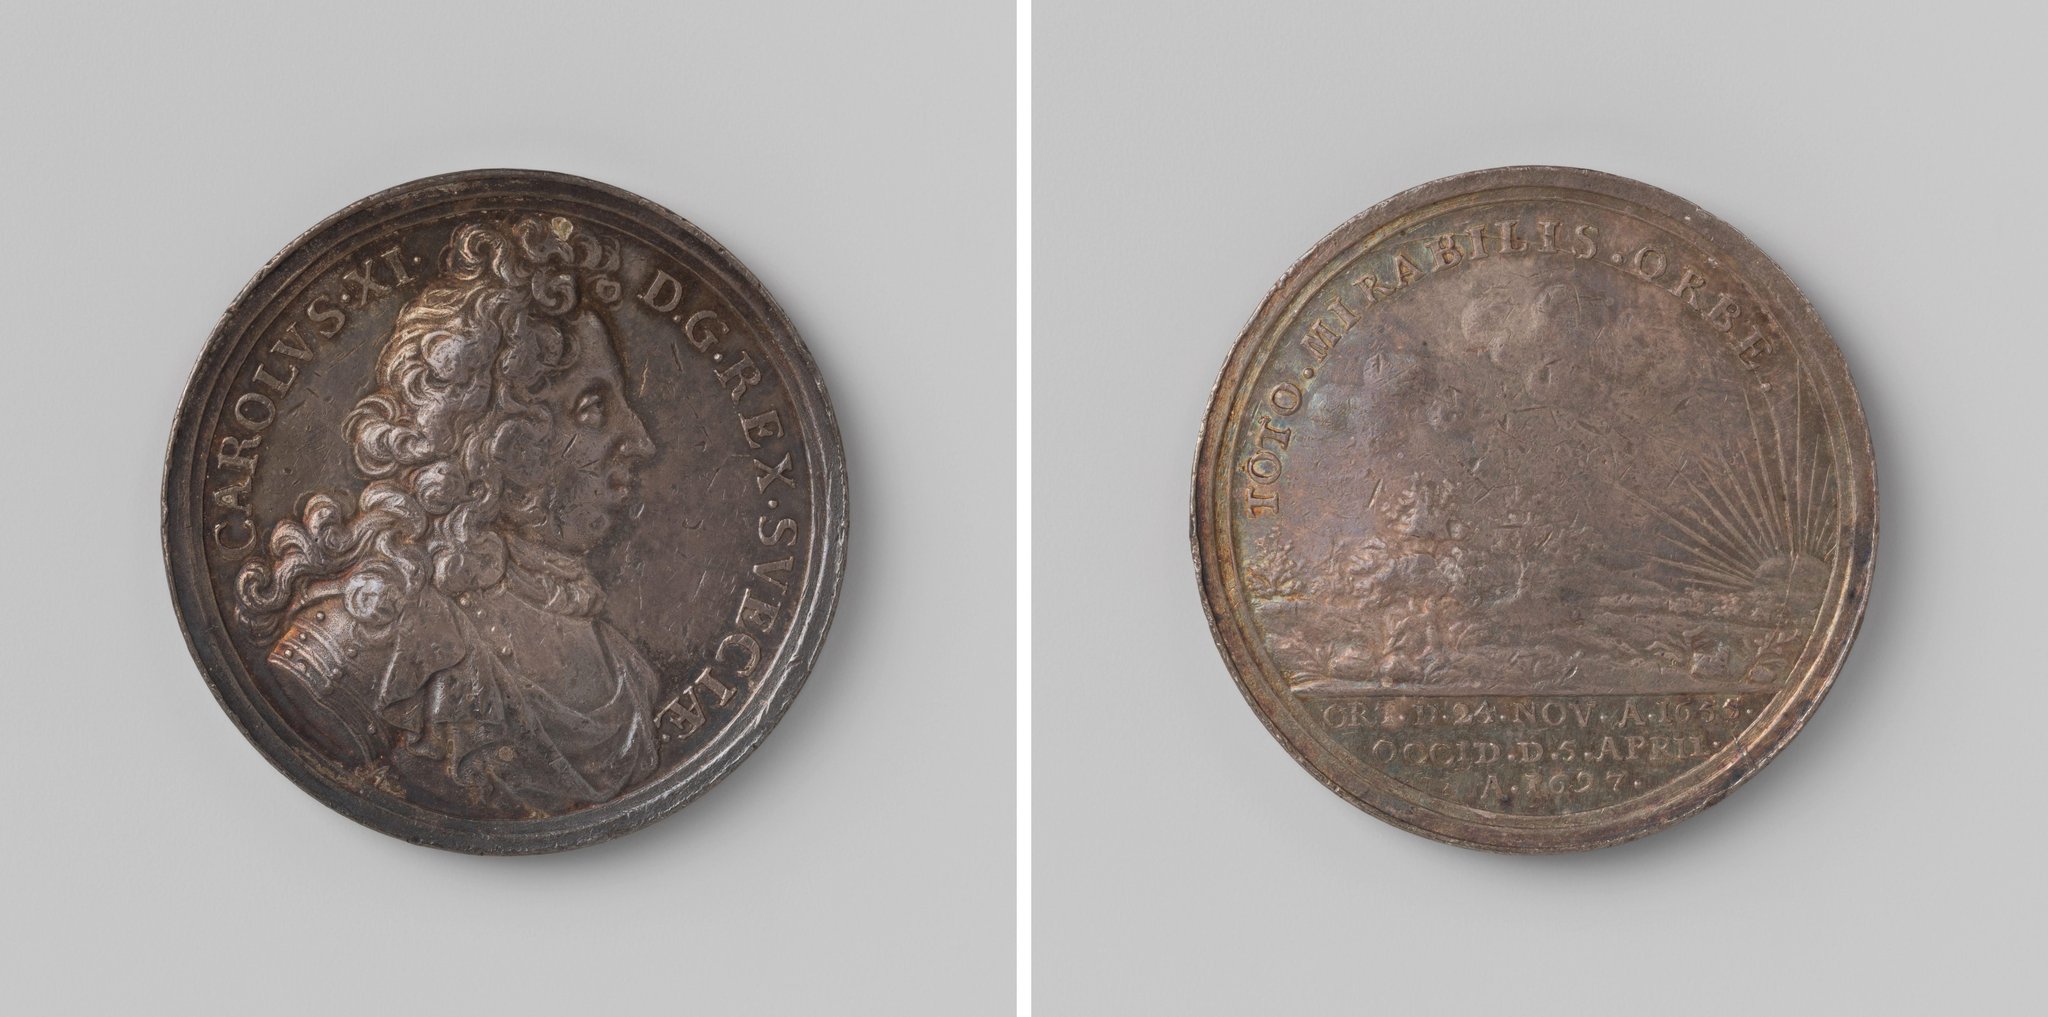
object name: history medal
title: Overlijden van Karel XI van Zweden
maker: arvid karlsteen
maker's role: medailleur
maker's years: 1647-1718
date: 1697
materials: silver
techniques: striking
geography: stockholm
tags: koning, karel xi (koning van zweden)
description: Zilveren penning. Voorzijde: borststuk man binnen omschrift. Keerzijde: landschap met ondergaande zon binnen omschrift; afsnede: opschrift